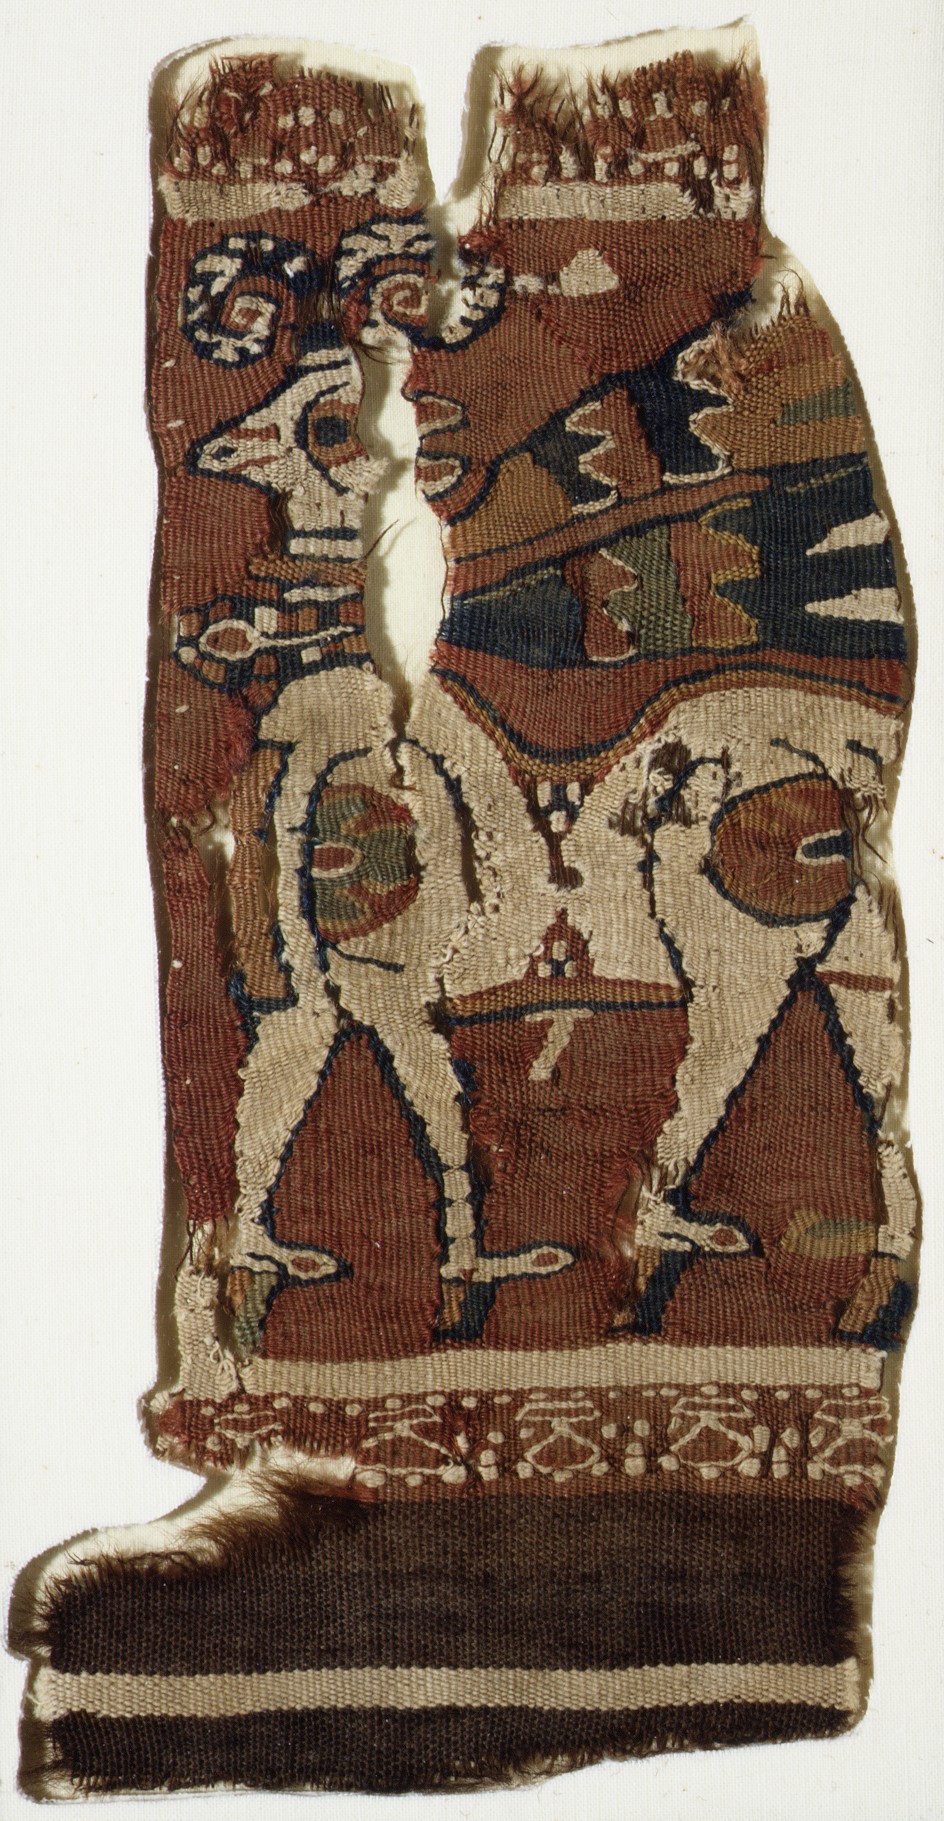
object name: textile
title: Textile fragment: walking ram with a neckband and fluttering ribbons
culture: sasanian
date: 601-700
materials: cotton, wool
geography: egypt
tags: rams